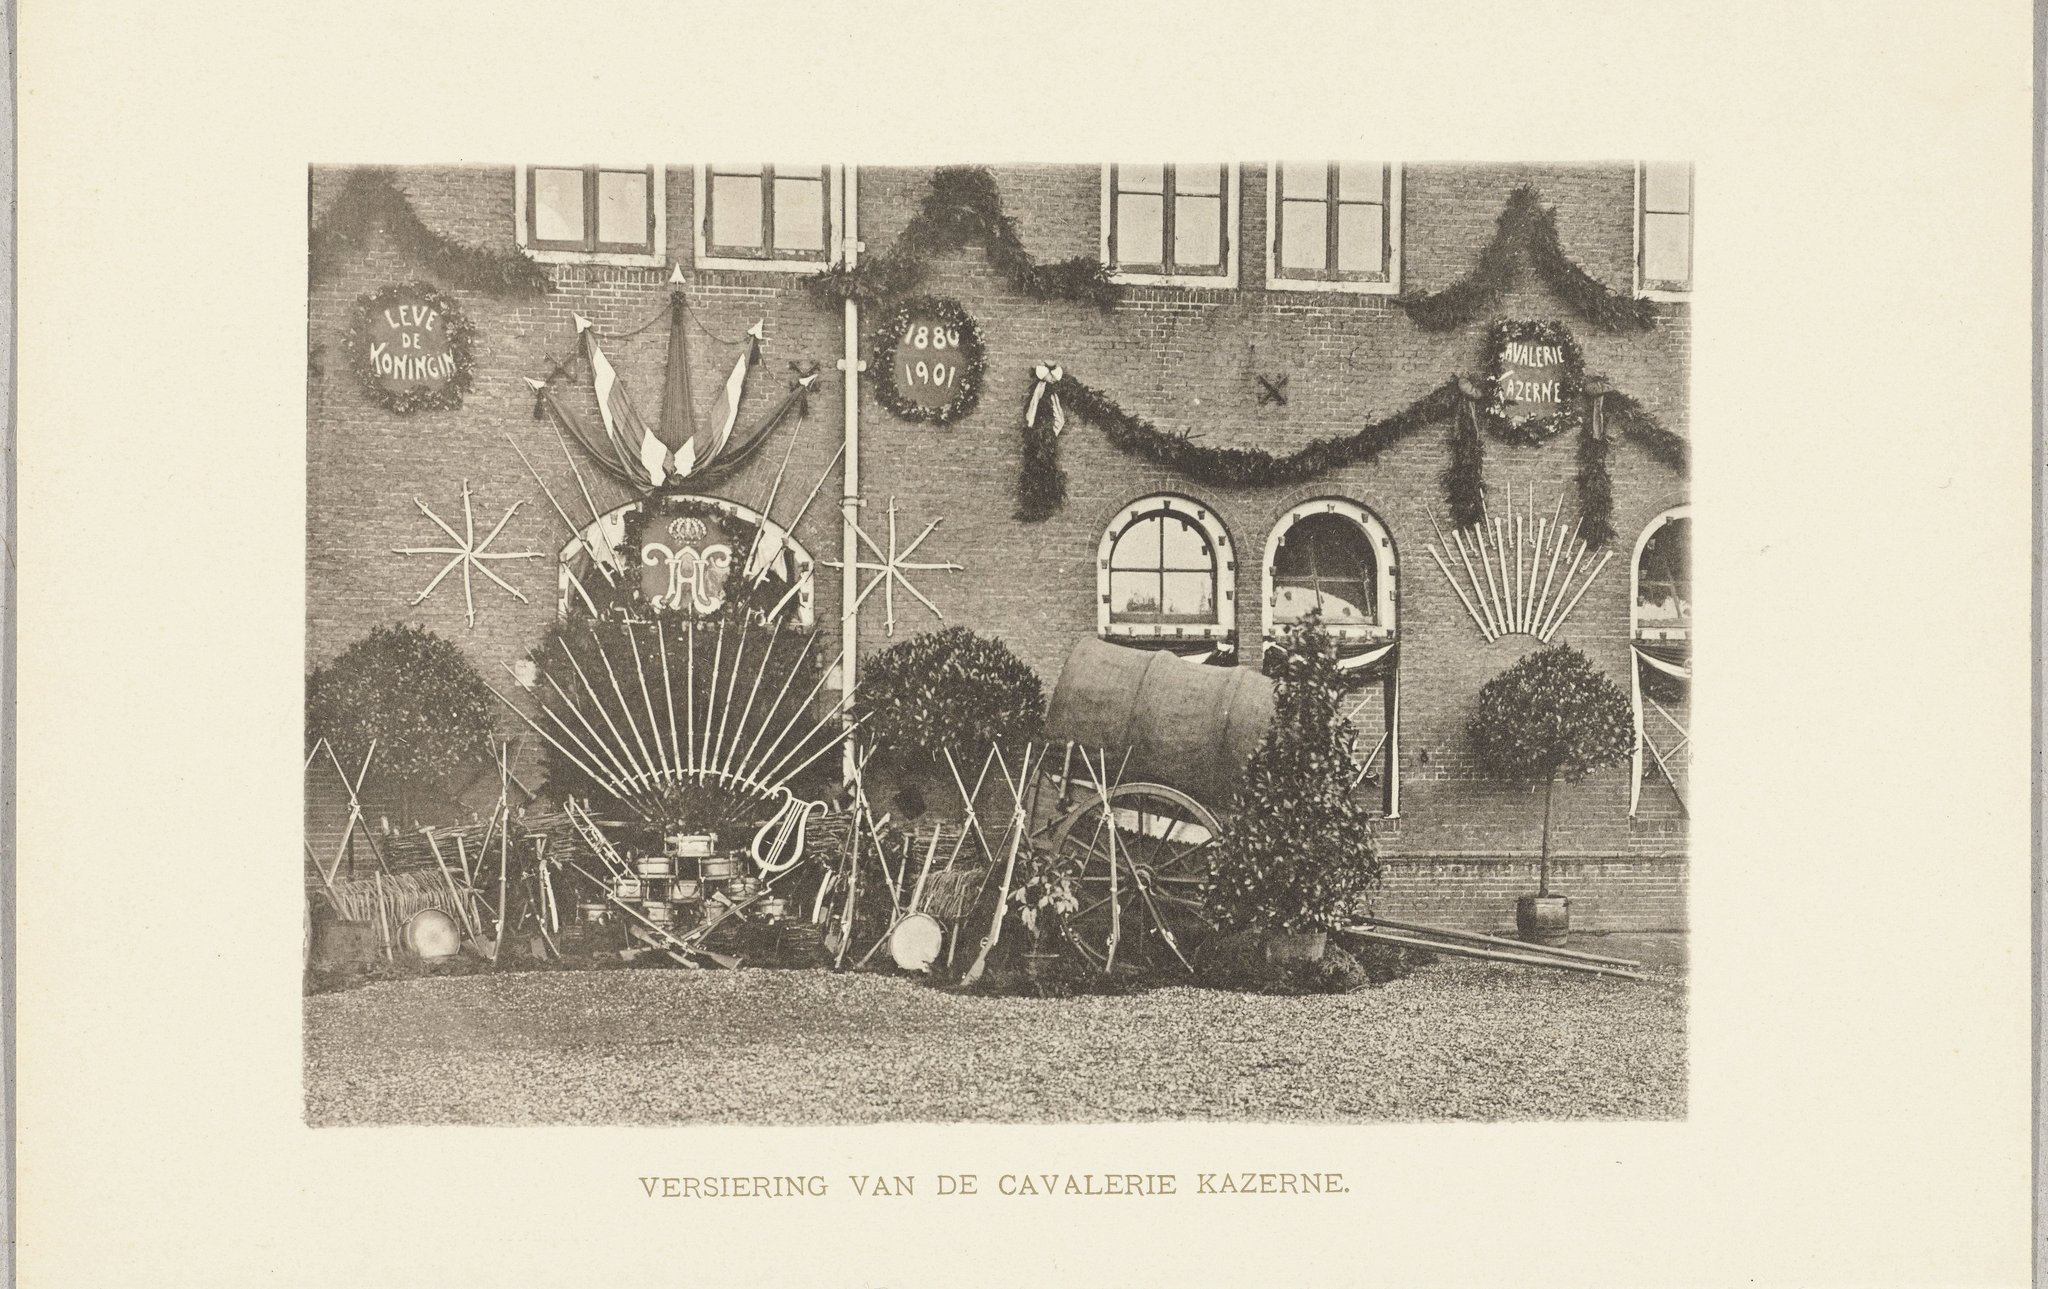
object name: photograph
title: Versiering van de Cavalerie Kazerne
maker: barend groote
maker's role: fotograaf, fotohandel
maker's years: 1862-1946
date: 1901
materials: paper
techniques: photograph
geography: amsterdam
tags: the hague, print maker, wilhelmina of the netherlands, decorations, honours (as symbols of the state, etc.), barracks, historical events and situations, amsterdam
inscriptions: annotation: ‘Versiering van de Cavalerie Kazerne’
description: Amsterdam, 5 februari 1901, feestelijkheden t.g.v. het huwelijk van koningin Wilhelmina en prins Hendrik